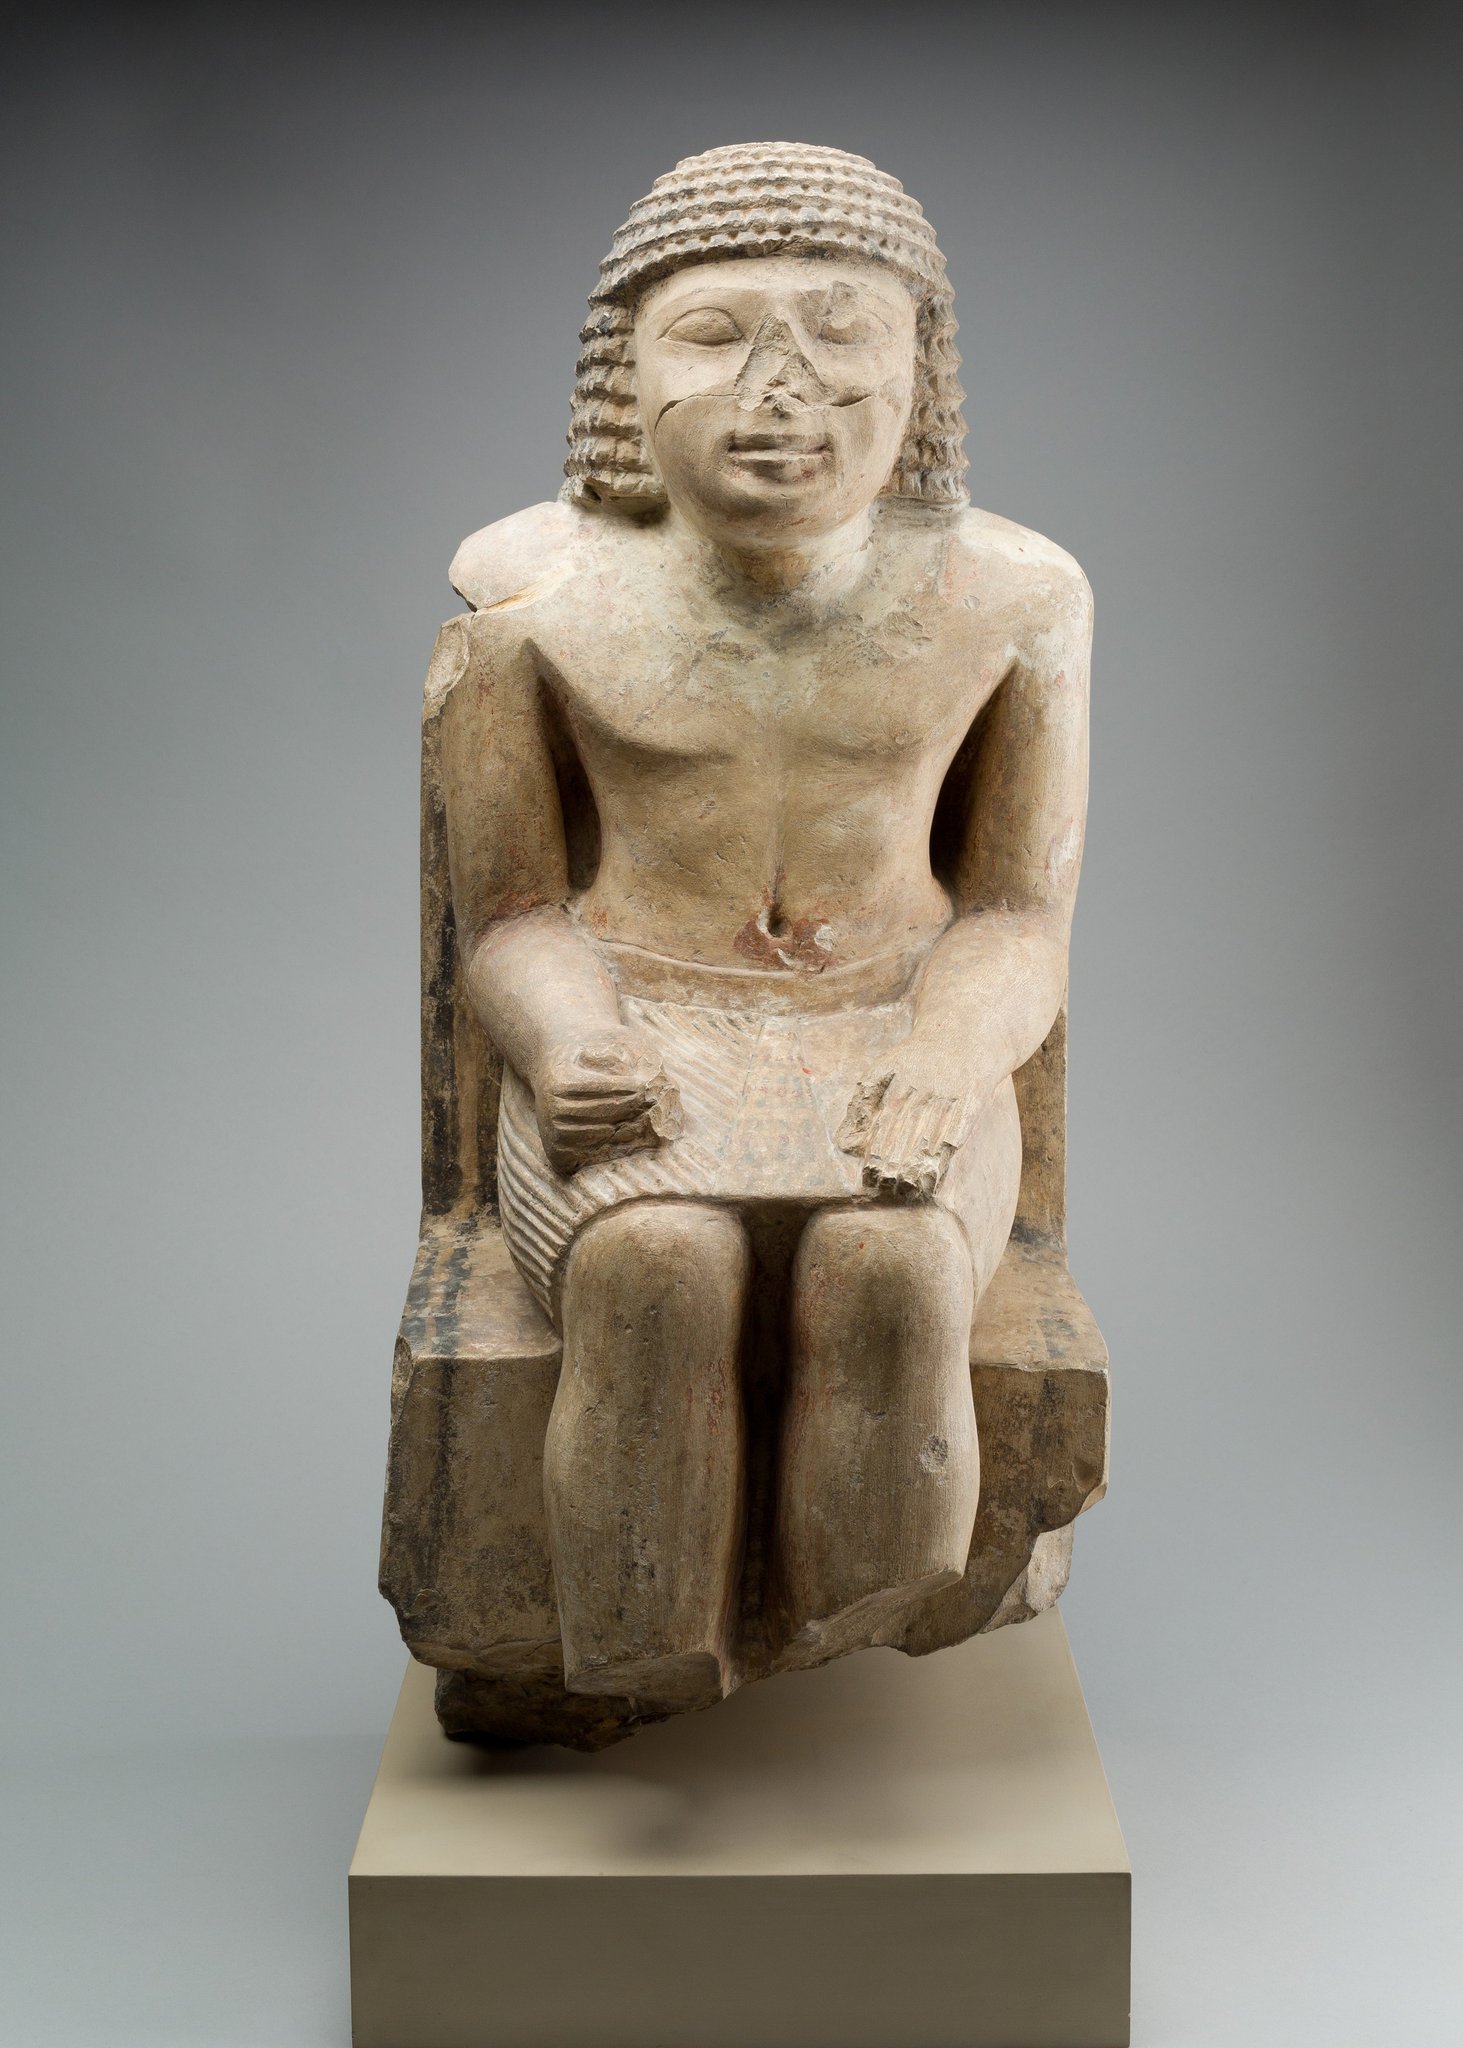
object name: statue, nomarch idu ii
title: Seated Statue of the Nomarch Idu II of Dendera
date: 2246-2152 BCE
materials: limestone, pigment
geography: egypt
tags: men